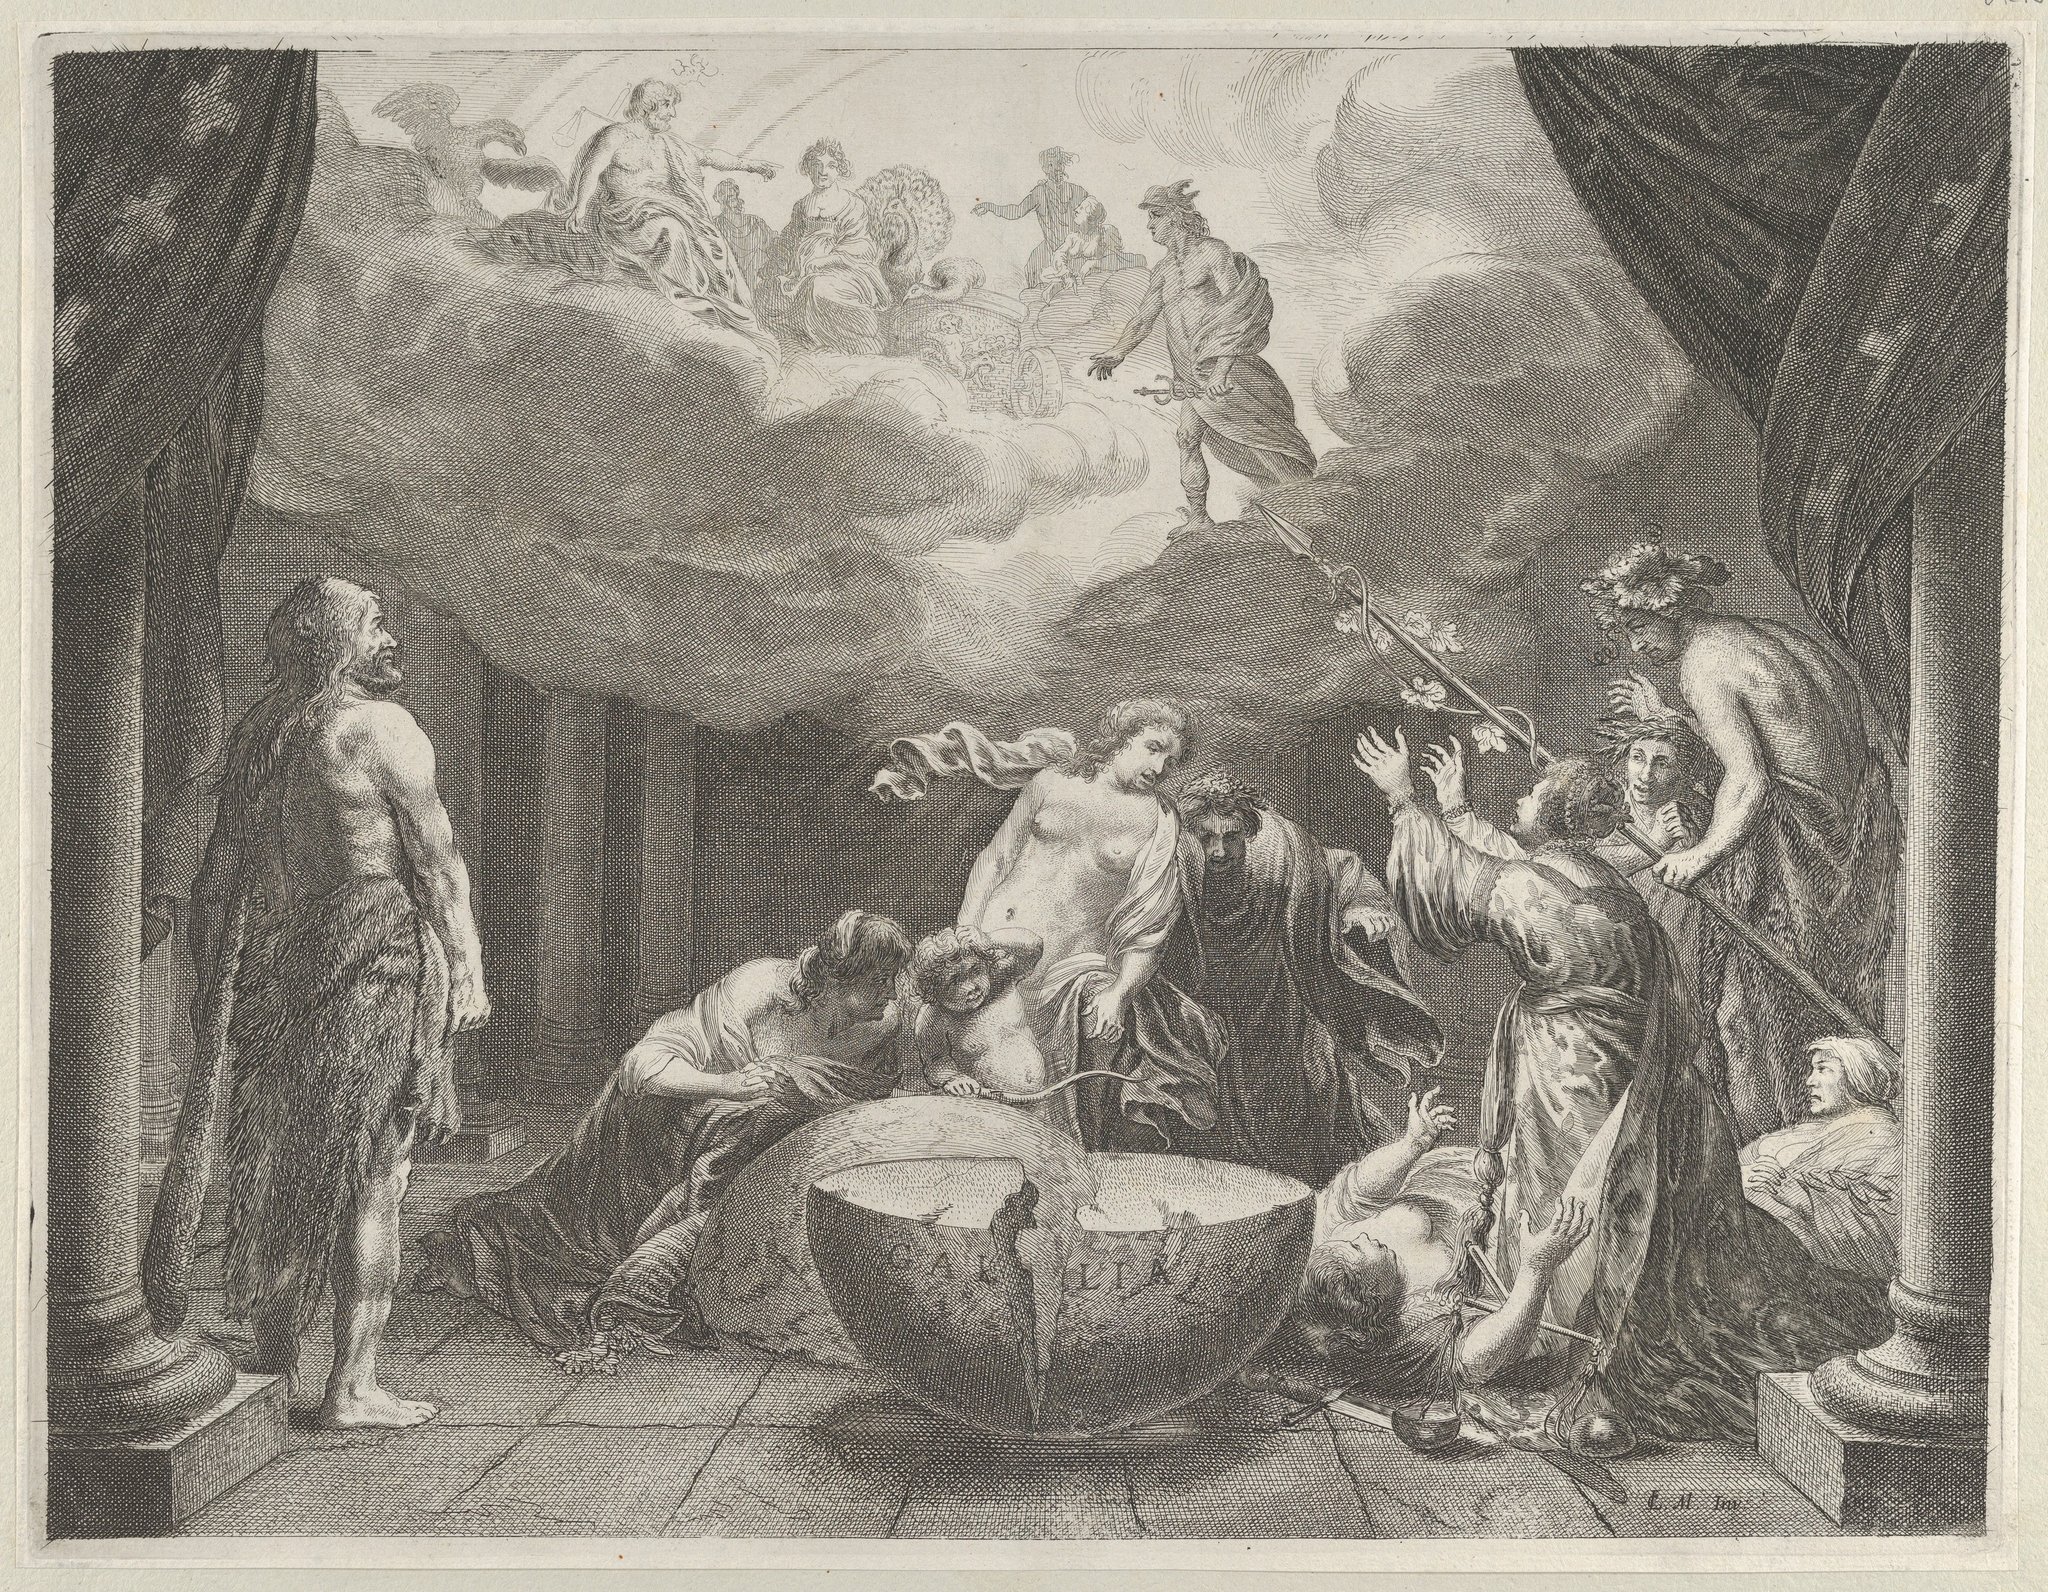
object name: print, fete, ornament architecture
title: Plate 10: Allegory on the Discord in France, from Caspar Barlaeus, "Medicea Hospes"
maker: pieter nolpe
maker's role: artist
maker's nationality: dutch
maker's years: 1613-1614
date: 1638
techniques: etching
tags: men,female nudes,hercules